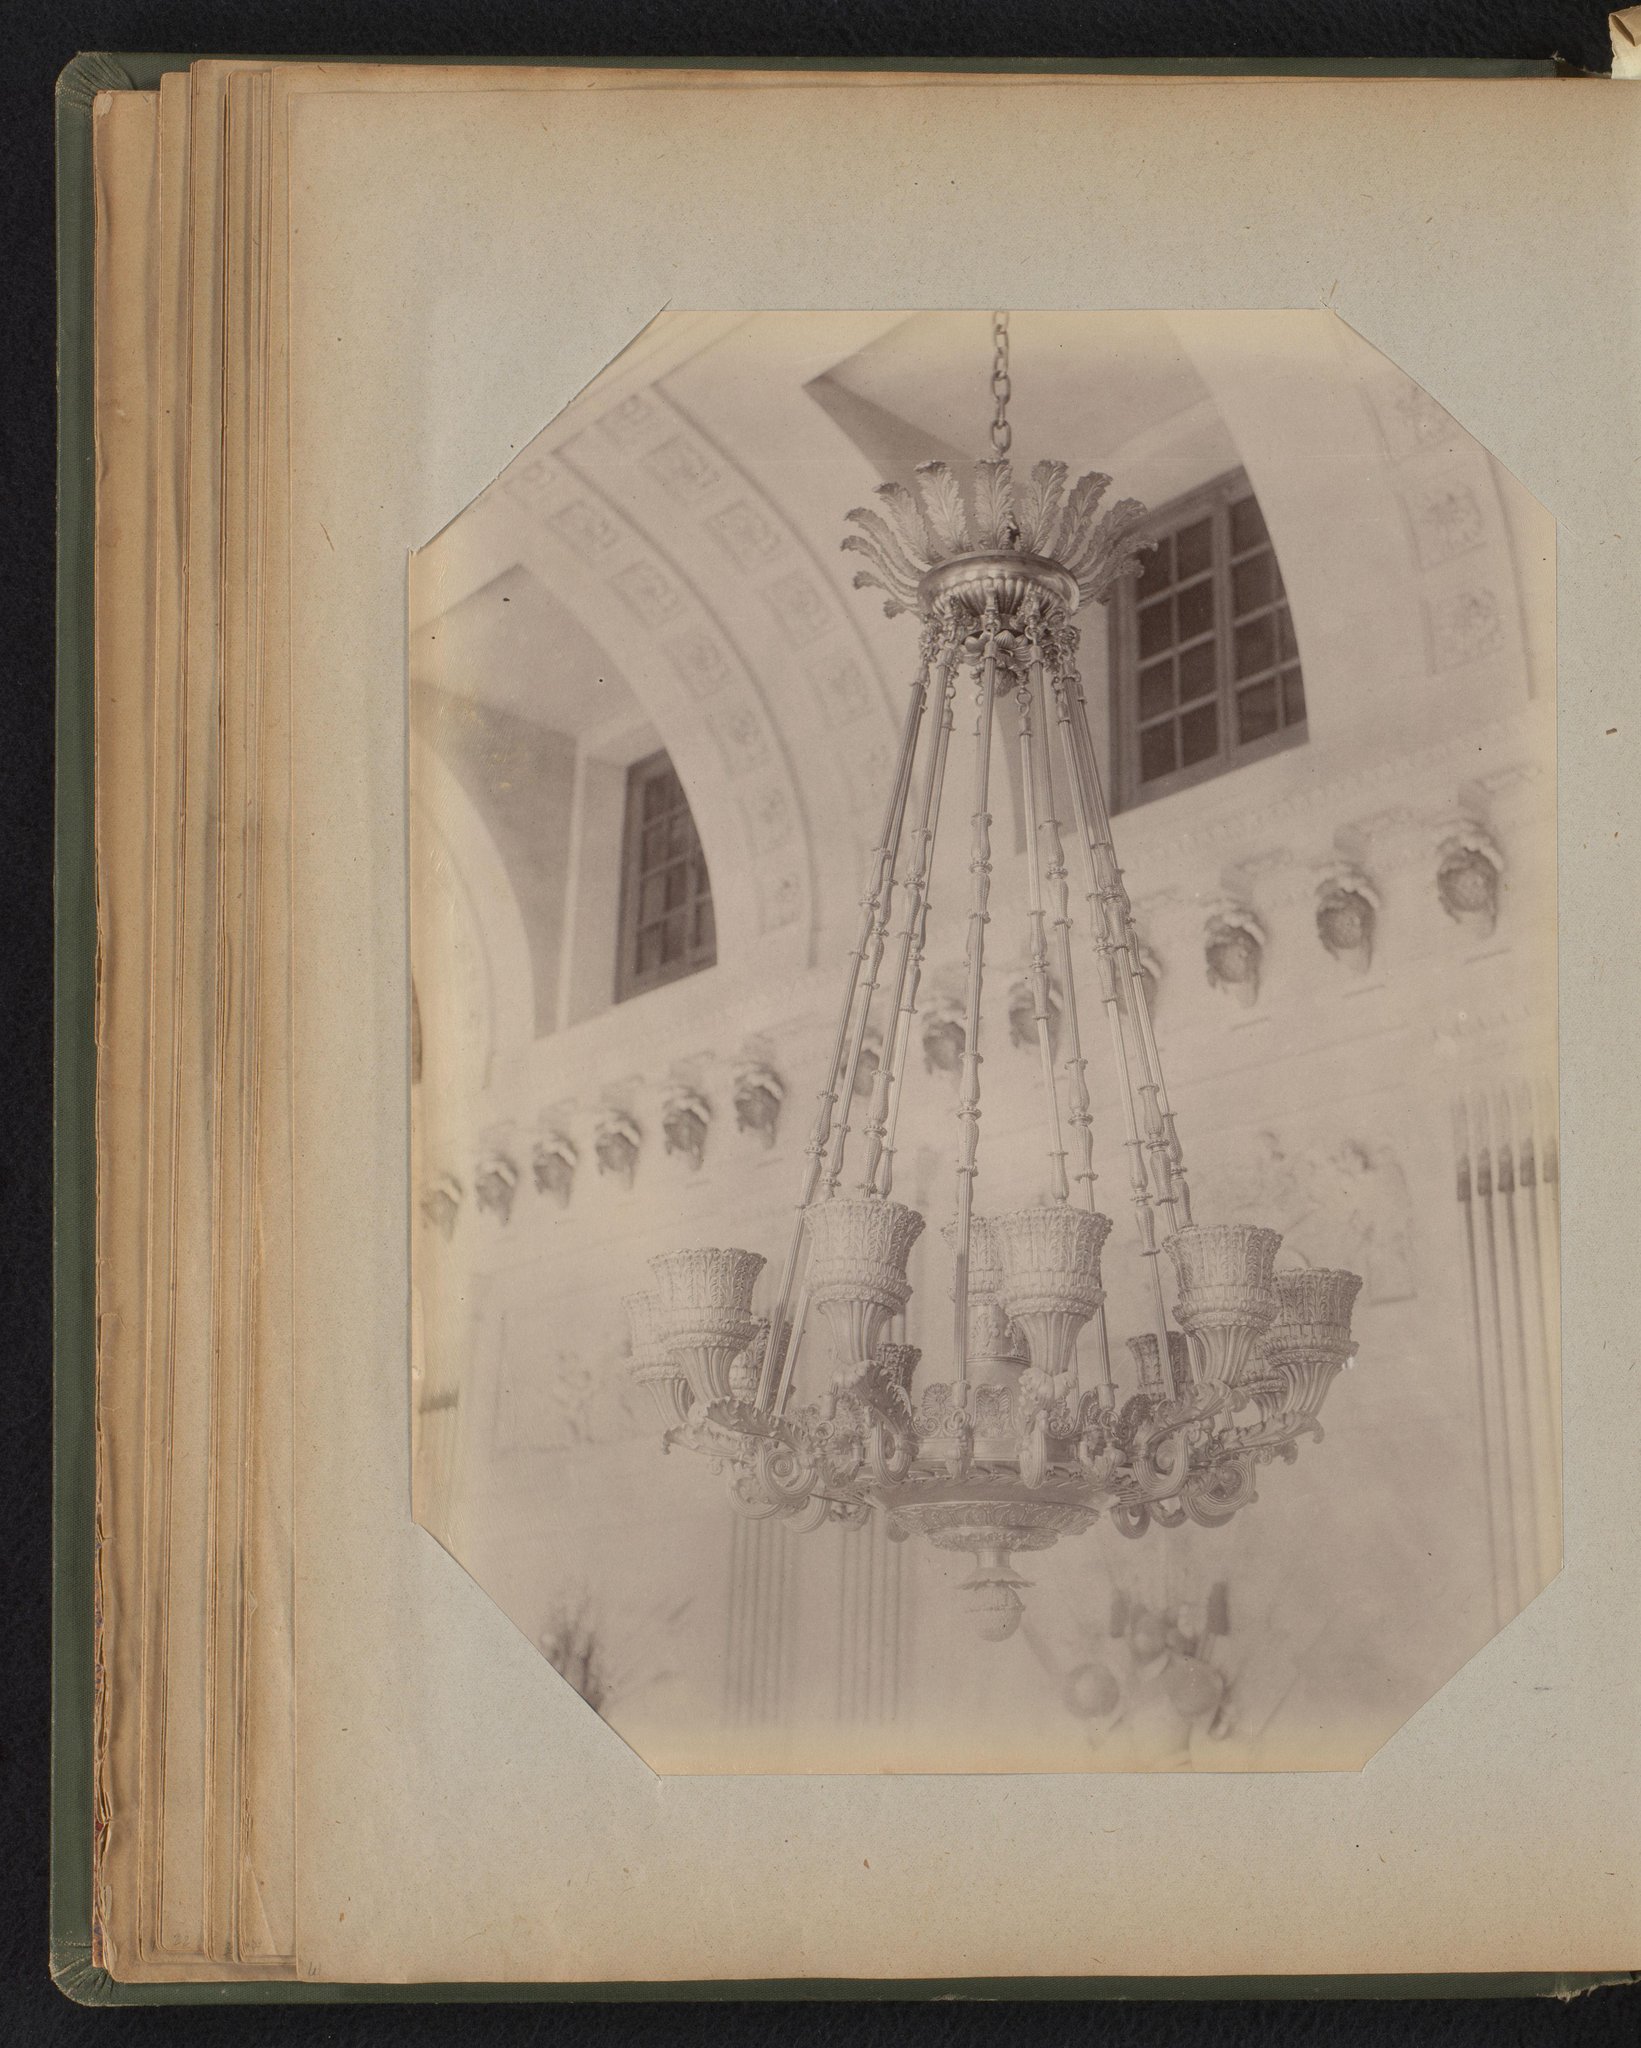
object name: photograph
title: Bronzen kroonluchter met bewerkte kandelaars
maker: Anonymous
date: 1860-1900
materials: paper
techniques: albumen print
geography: netherlands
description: Onderdeel van een serie met betrekking tot het interieur van het paleis van Versailles met kroonluchters, deuren, portalen en meubelstukken.